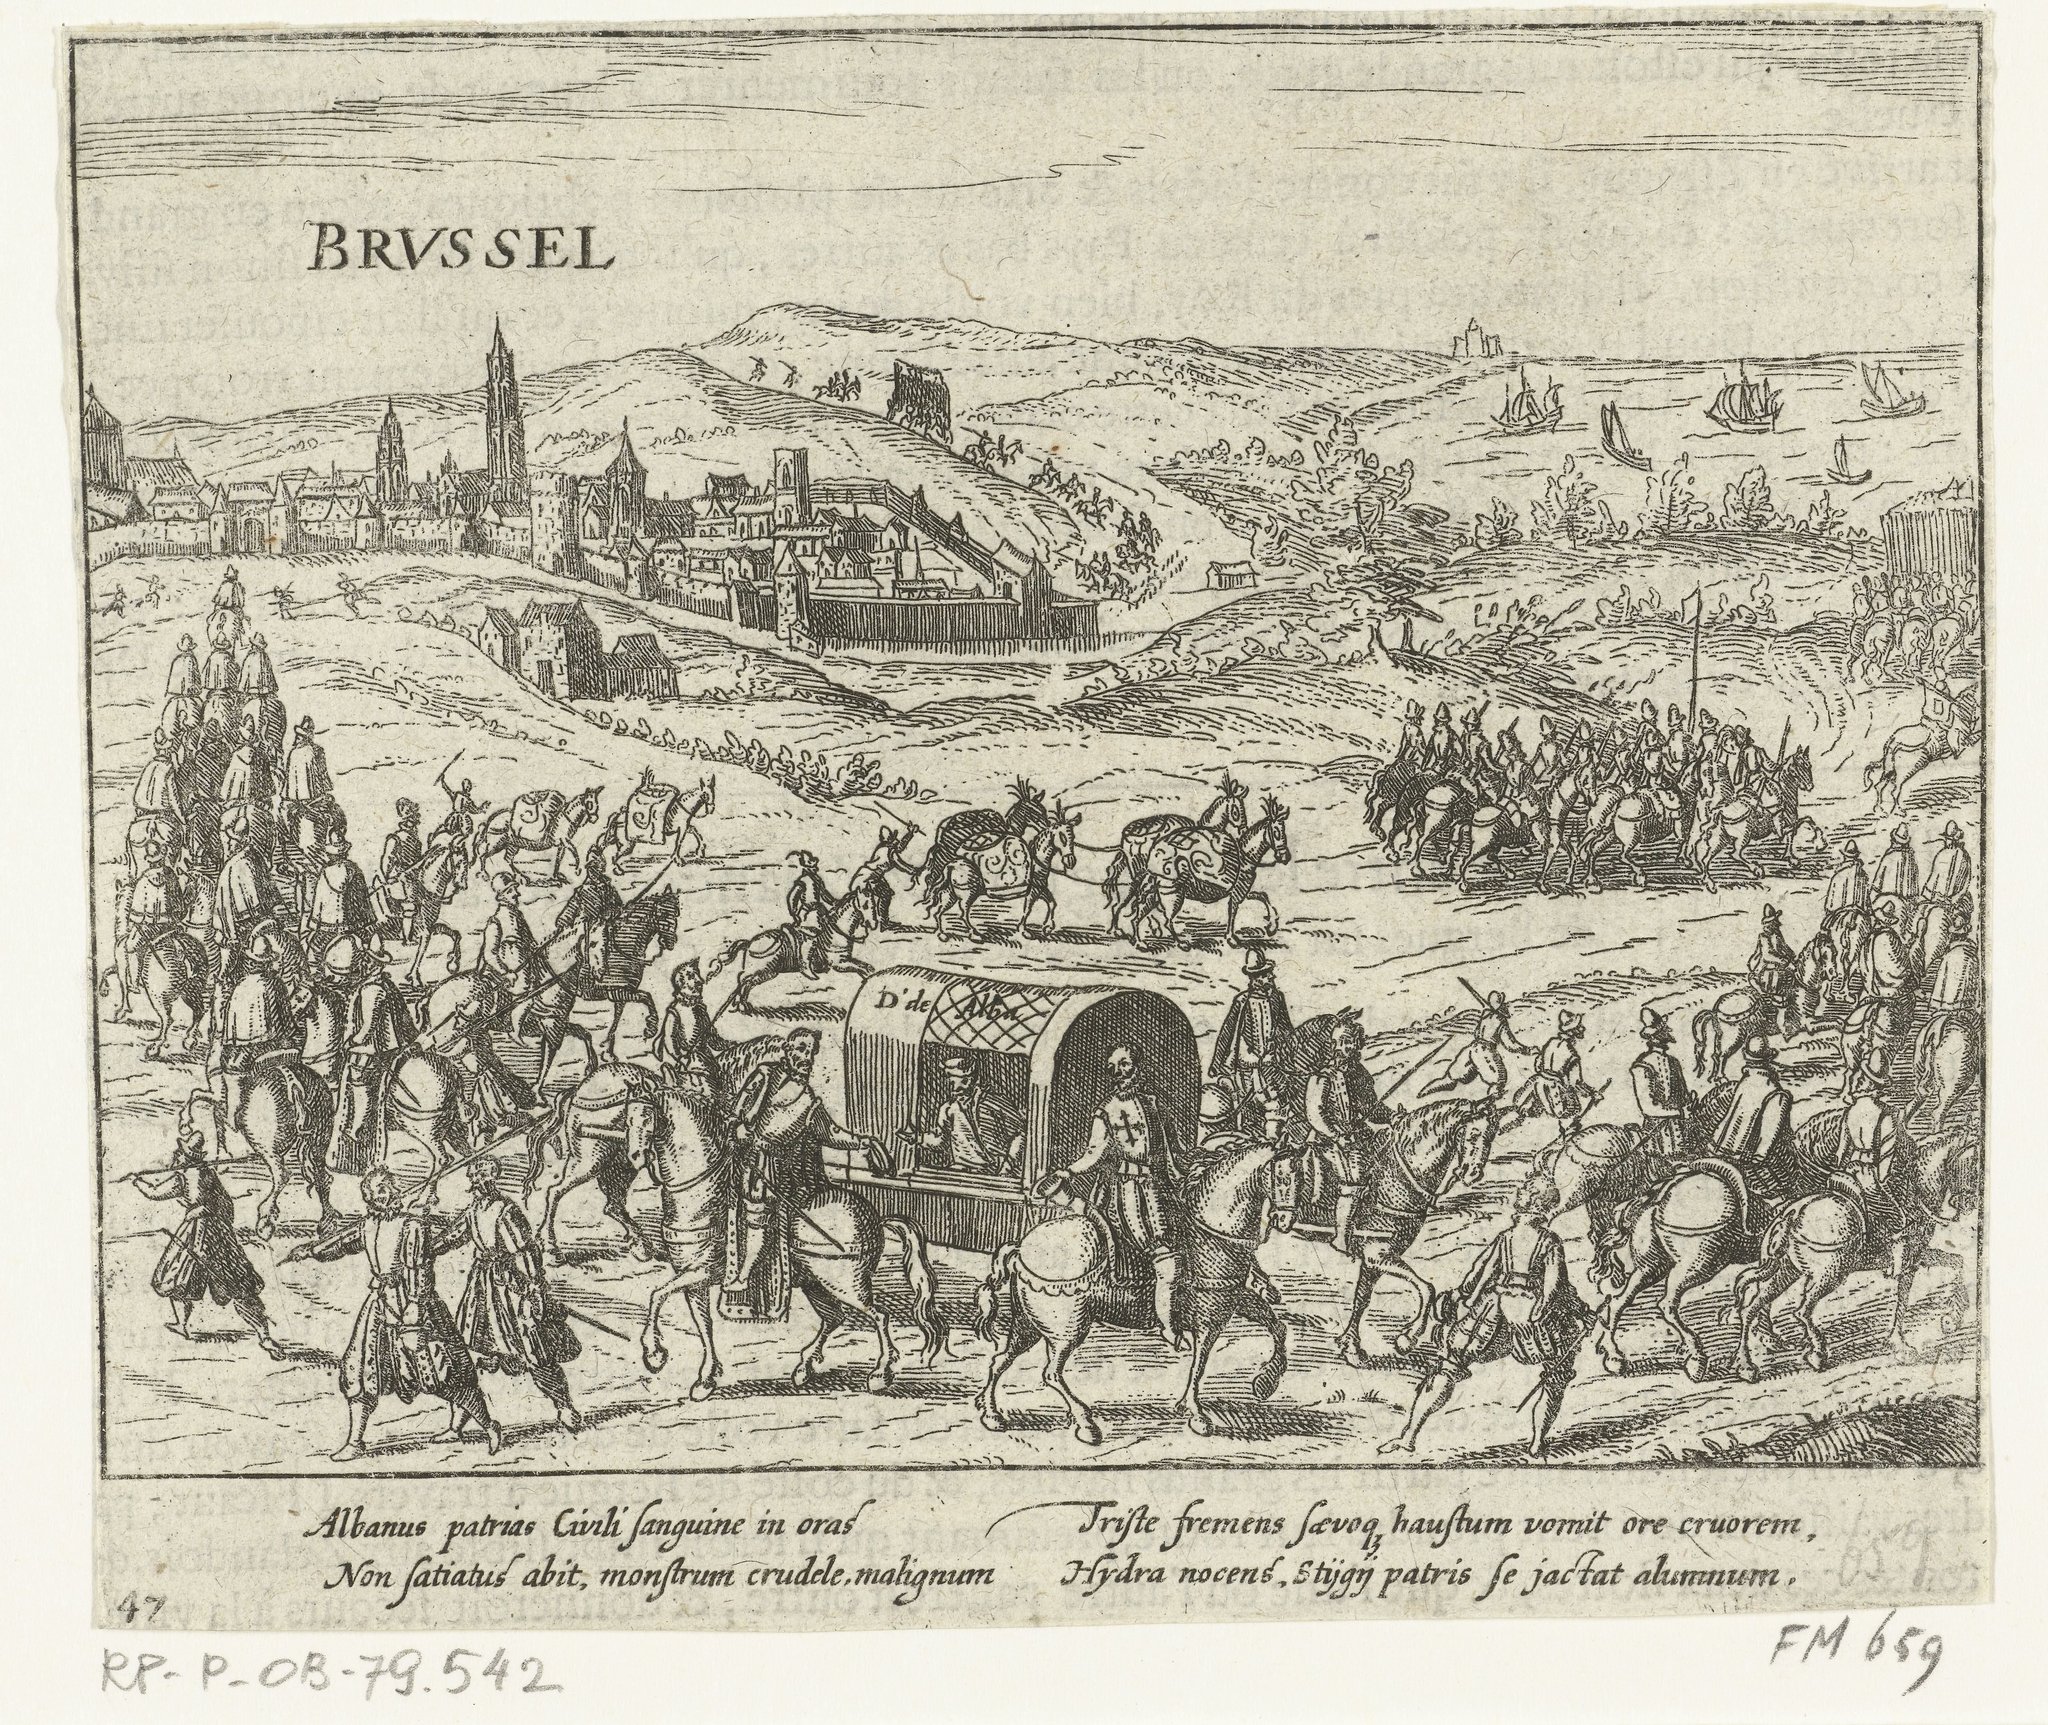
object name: history print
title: Alva verlaat de Nederlanden, 1573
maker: Anonymous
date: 1613-1615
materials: paper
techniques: etching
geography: northern netherlands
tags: fernando álvarez de toledo (3rd duke of alba), brussels, mayor, luis de zúñiga y requesens, (carrying a person in a) sedan-chair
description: Alva verlaat de Nederlanden, december 1573. In een grote stoet vertrekt de hertog in een draagstoel uit Brussel naar Spanje. Hij groet de nieuwe landvoogd Requesens die richting Brussel rijdt. Met onderschrift van 4 regels in het Latijn. Genummerd: 47. Bedrukt op achterzijde met tekst in het Frans.